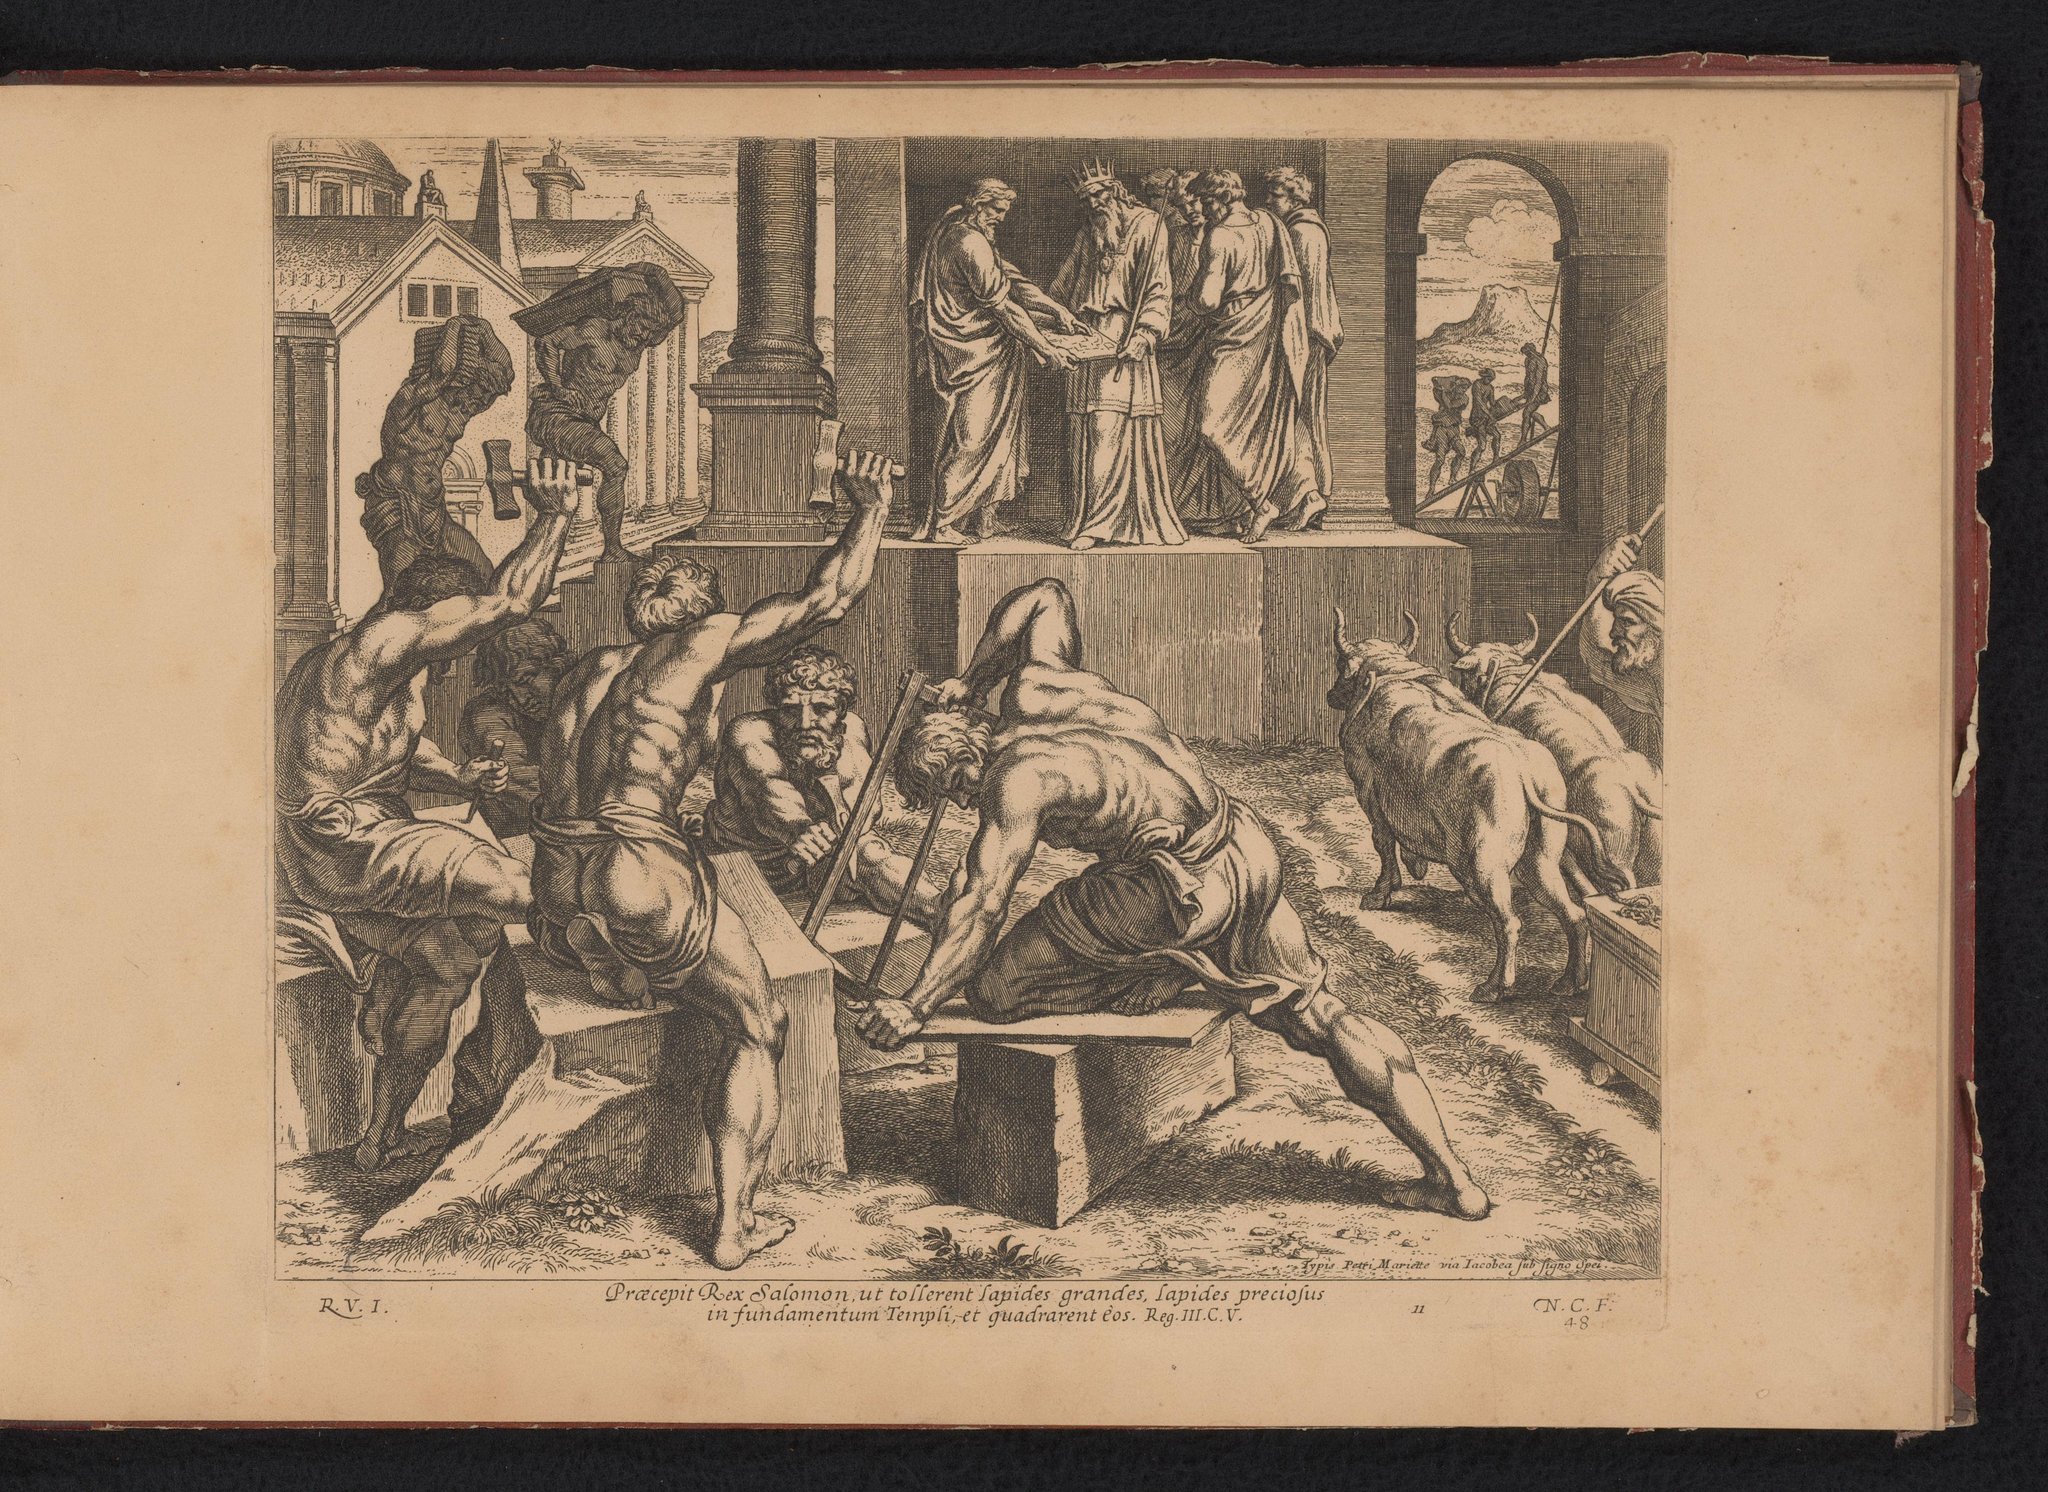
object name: album leaf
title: Rafaël Bijbel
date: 1649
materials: paper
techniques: etching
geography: paris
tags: the building of the temple of solomon, solomon supervising the work ~ temple of solomon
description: Deze prent maakt deel uit van een album.